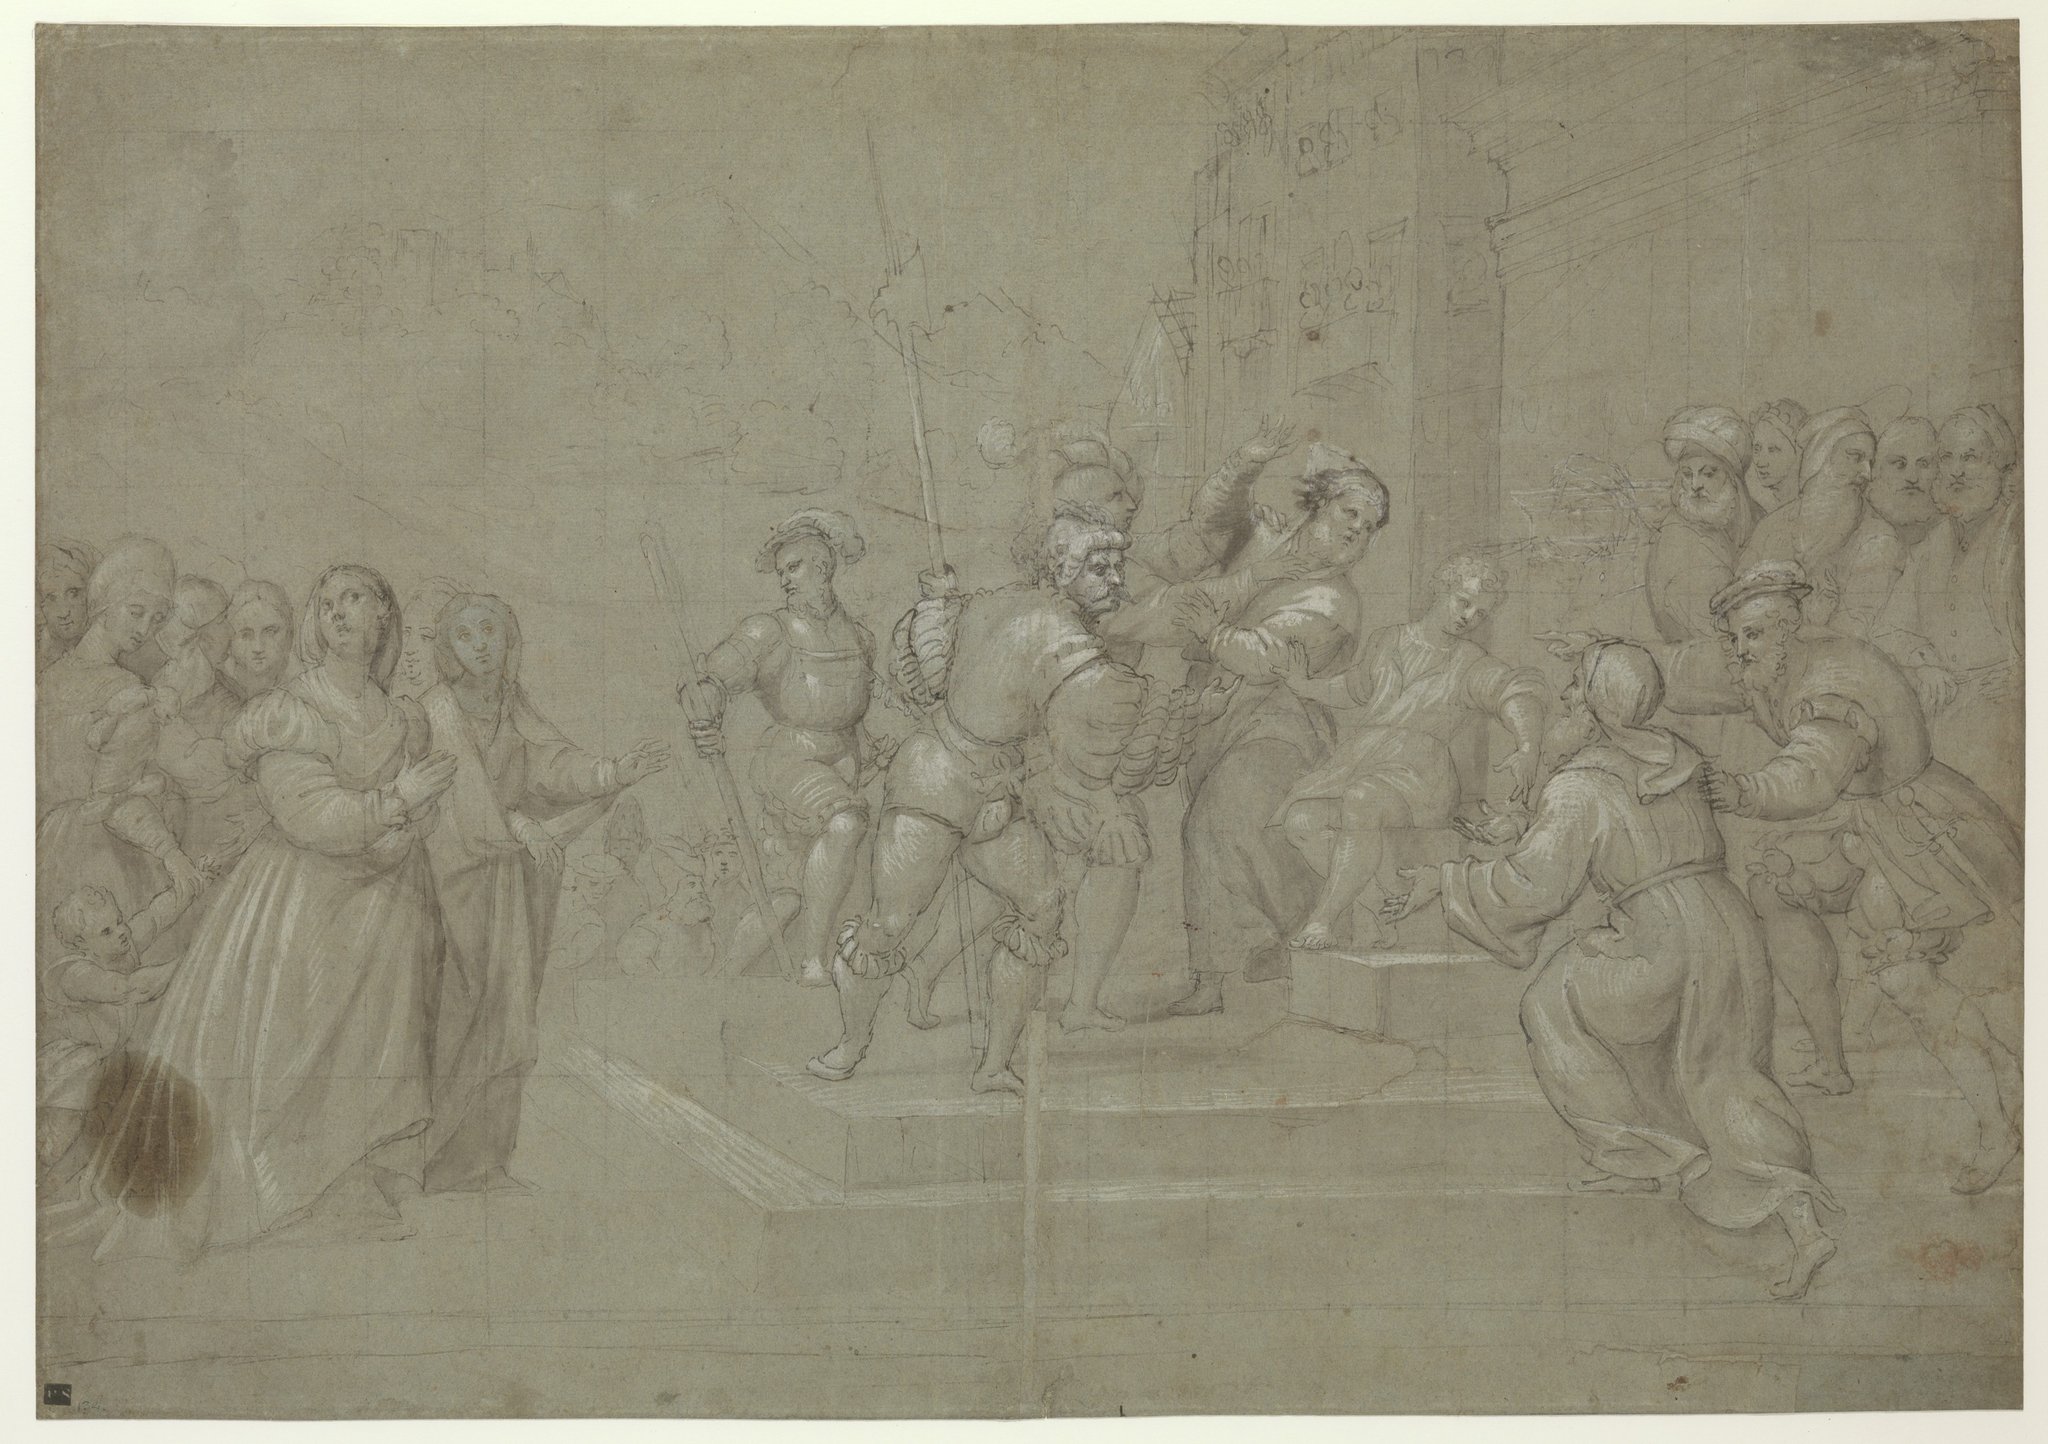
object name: drawing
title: Susannah and the Elders before Daniel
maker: pomponio amalteo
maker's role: artist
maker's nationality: italian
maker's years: 1505-1588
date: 1530-1540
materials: chalk, ink, paper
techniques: brush, highlighting, pen, drawing, wash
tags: soldiers,weapons,men,women